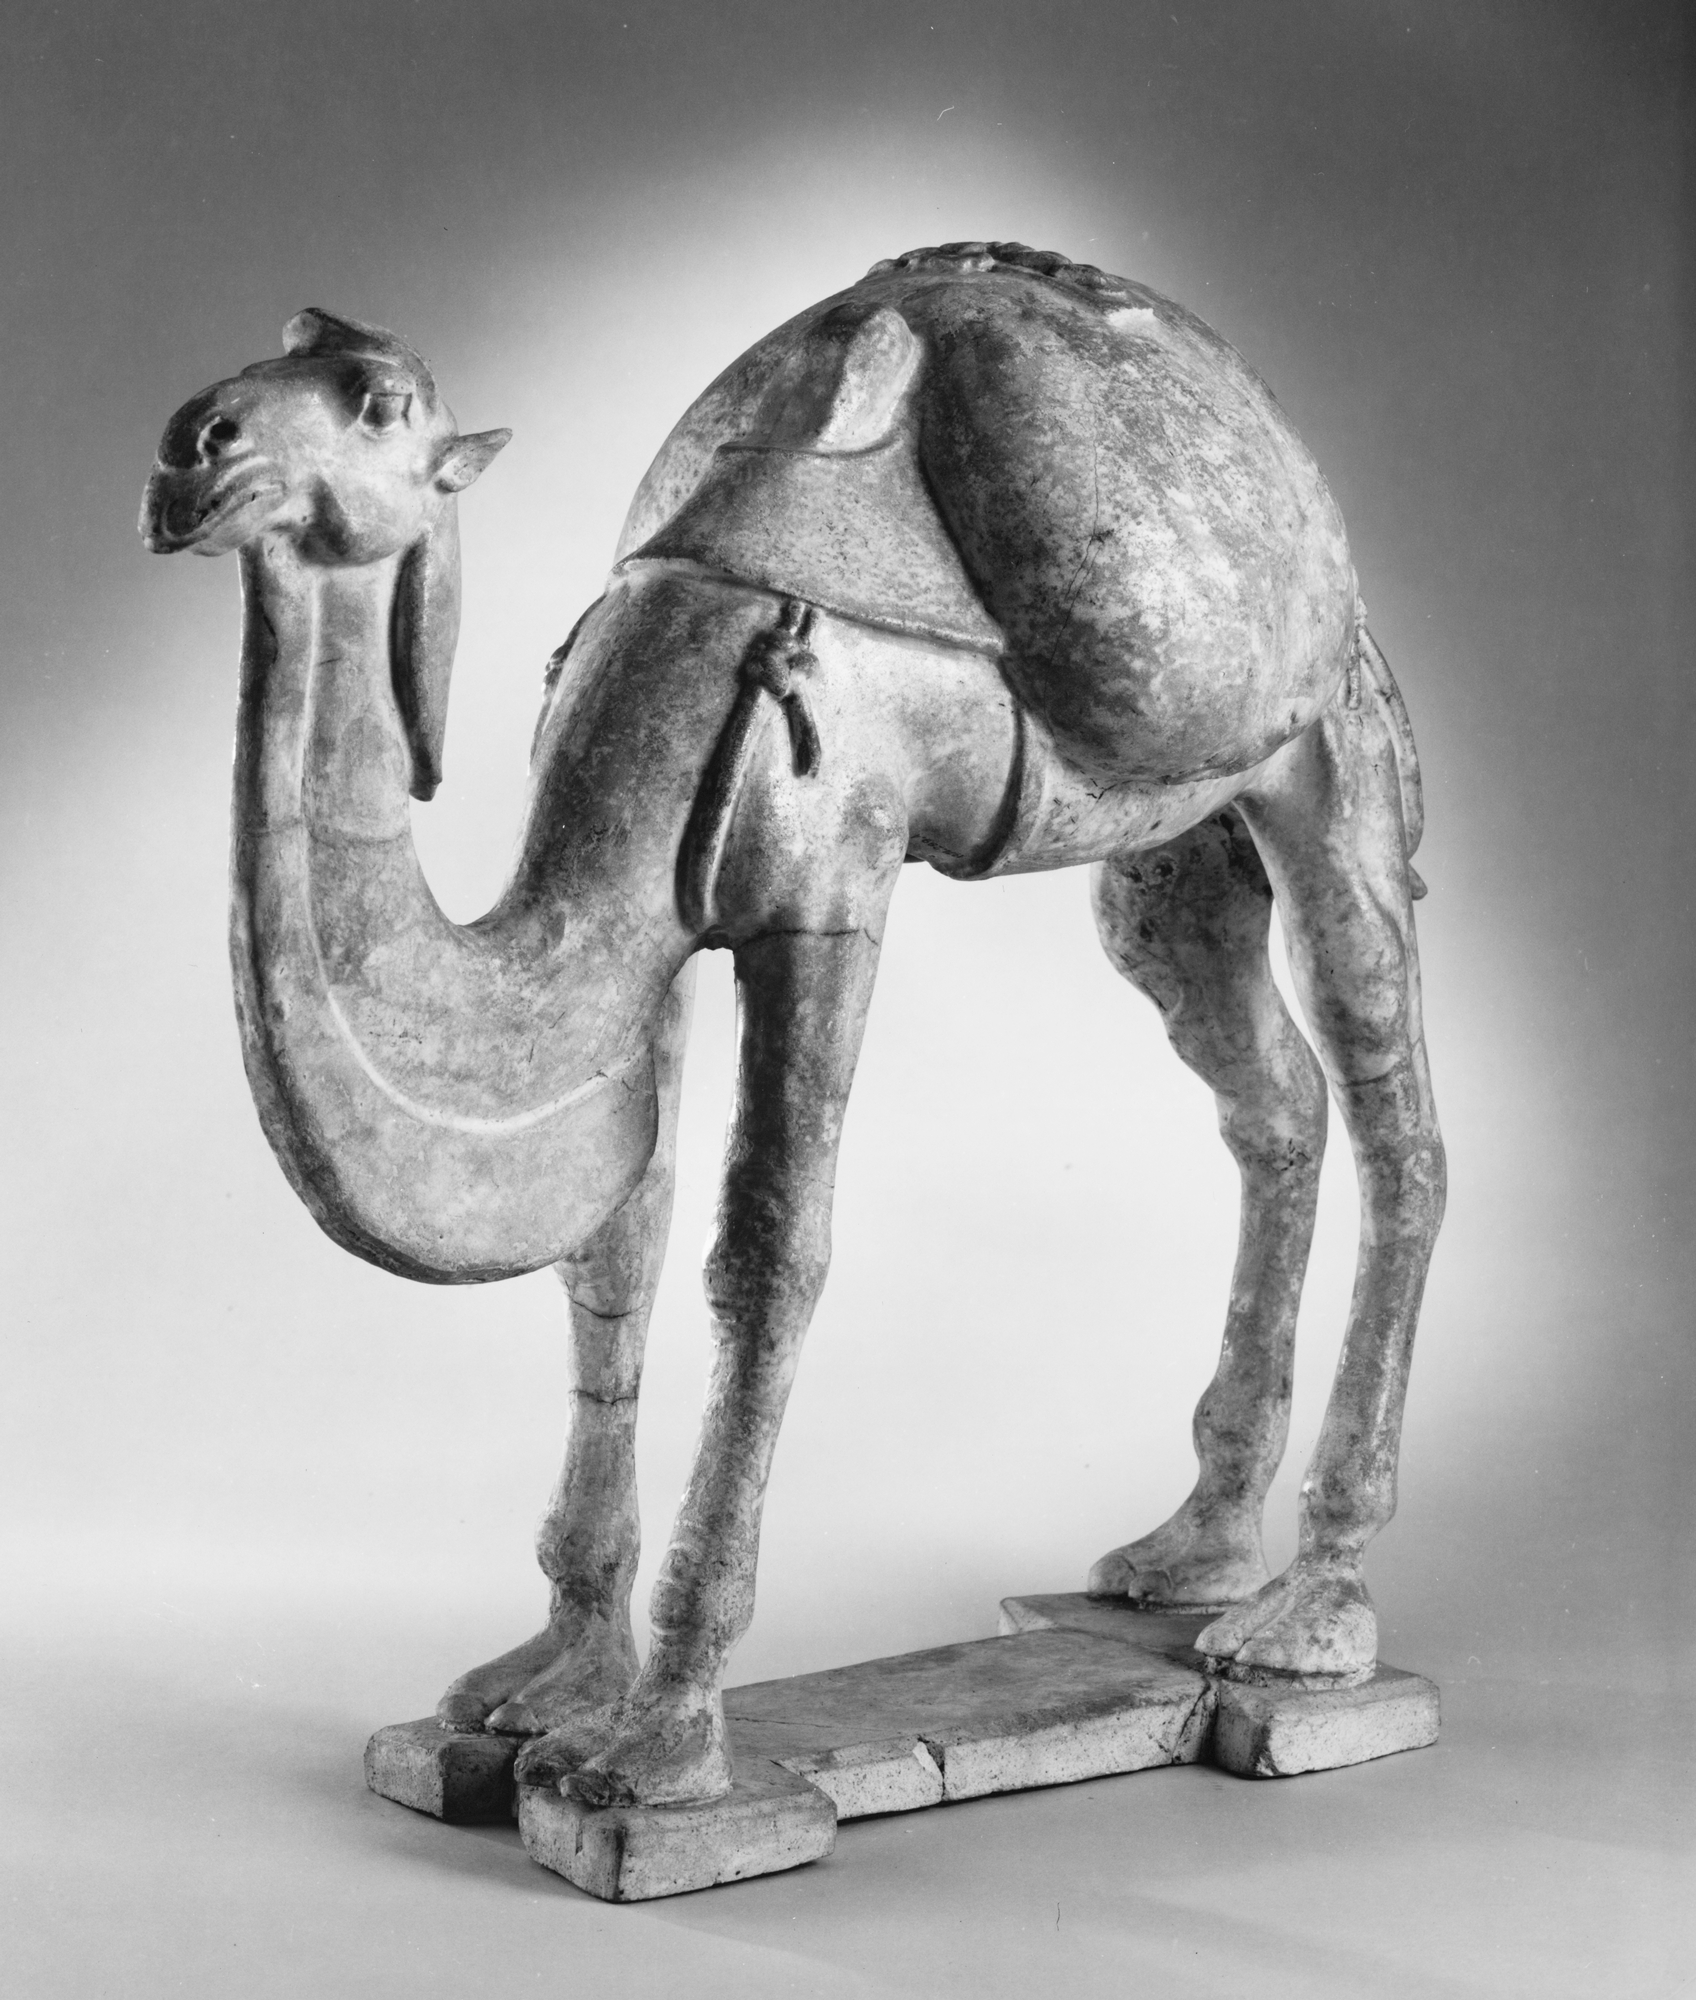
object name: figure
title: Camel with saddle bags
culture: chinese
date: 567-633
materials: earthenware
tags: camels